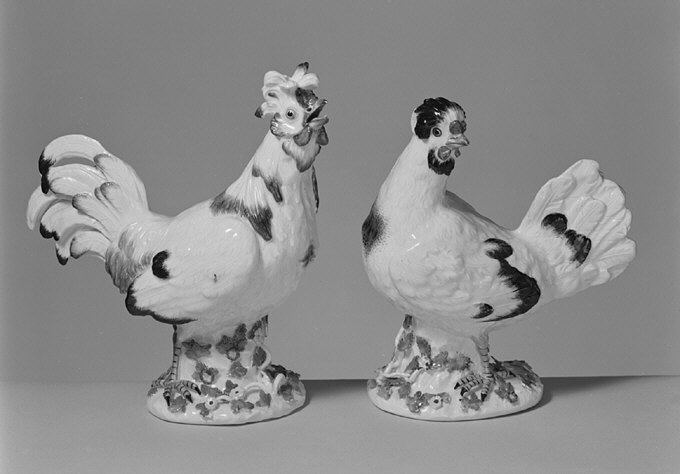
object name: figure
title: Rooster (one of a pair)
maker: meissen manufactory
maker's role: manufactory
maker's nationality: german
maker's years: 1710-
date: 1742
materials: hard paste porcelain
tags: roosters